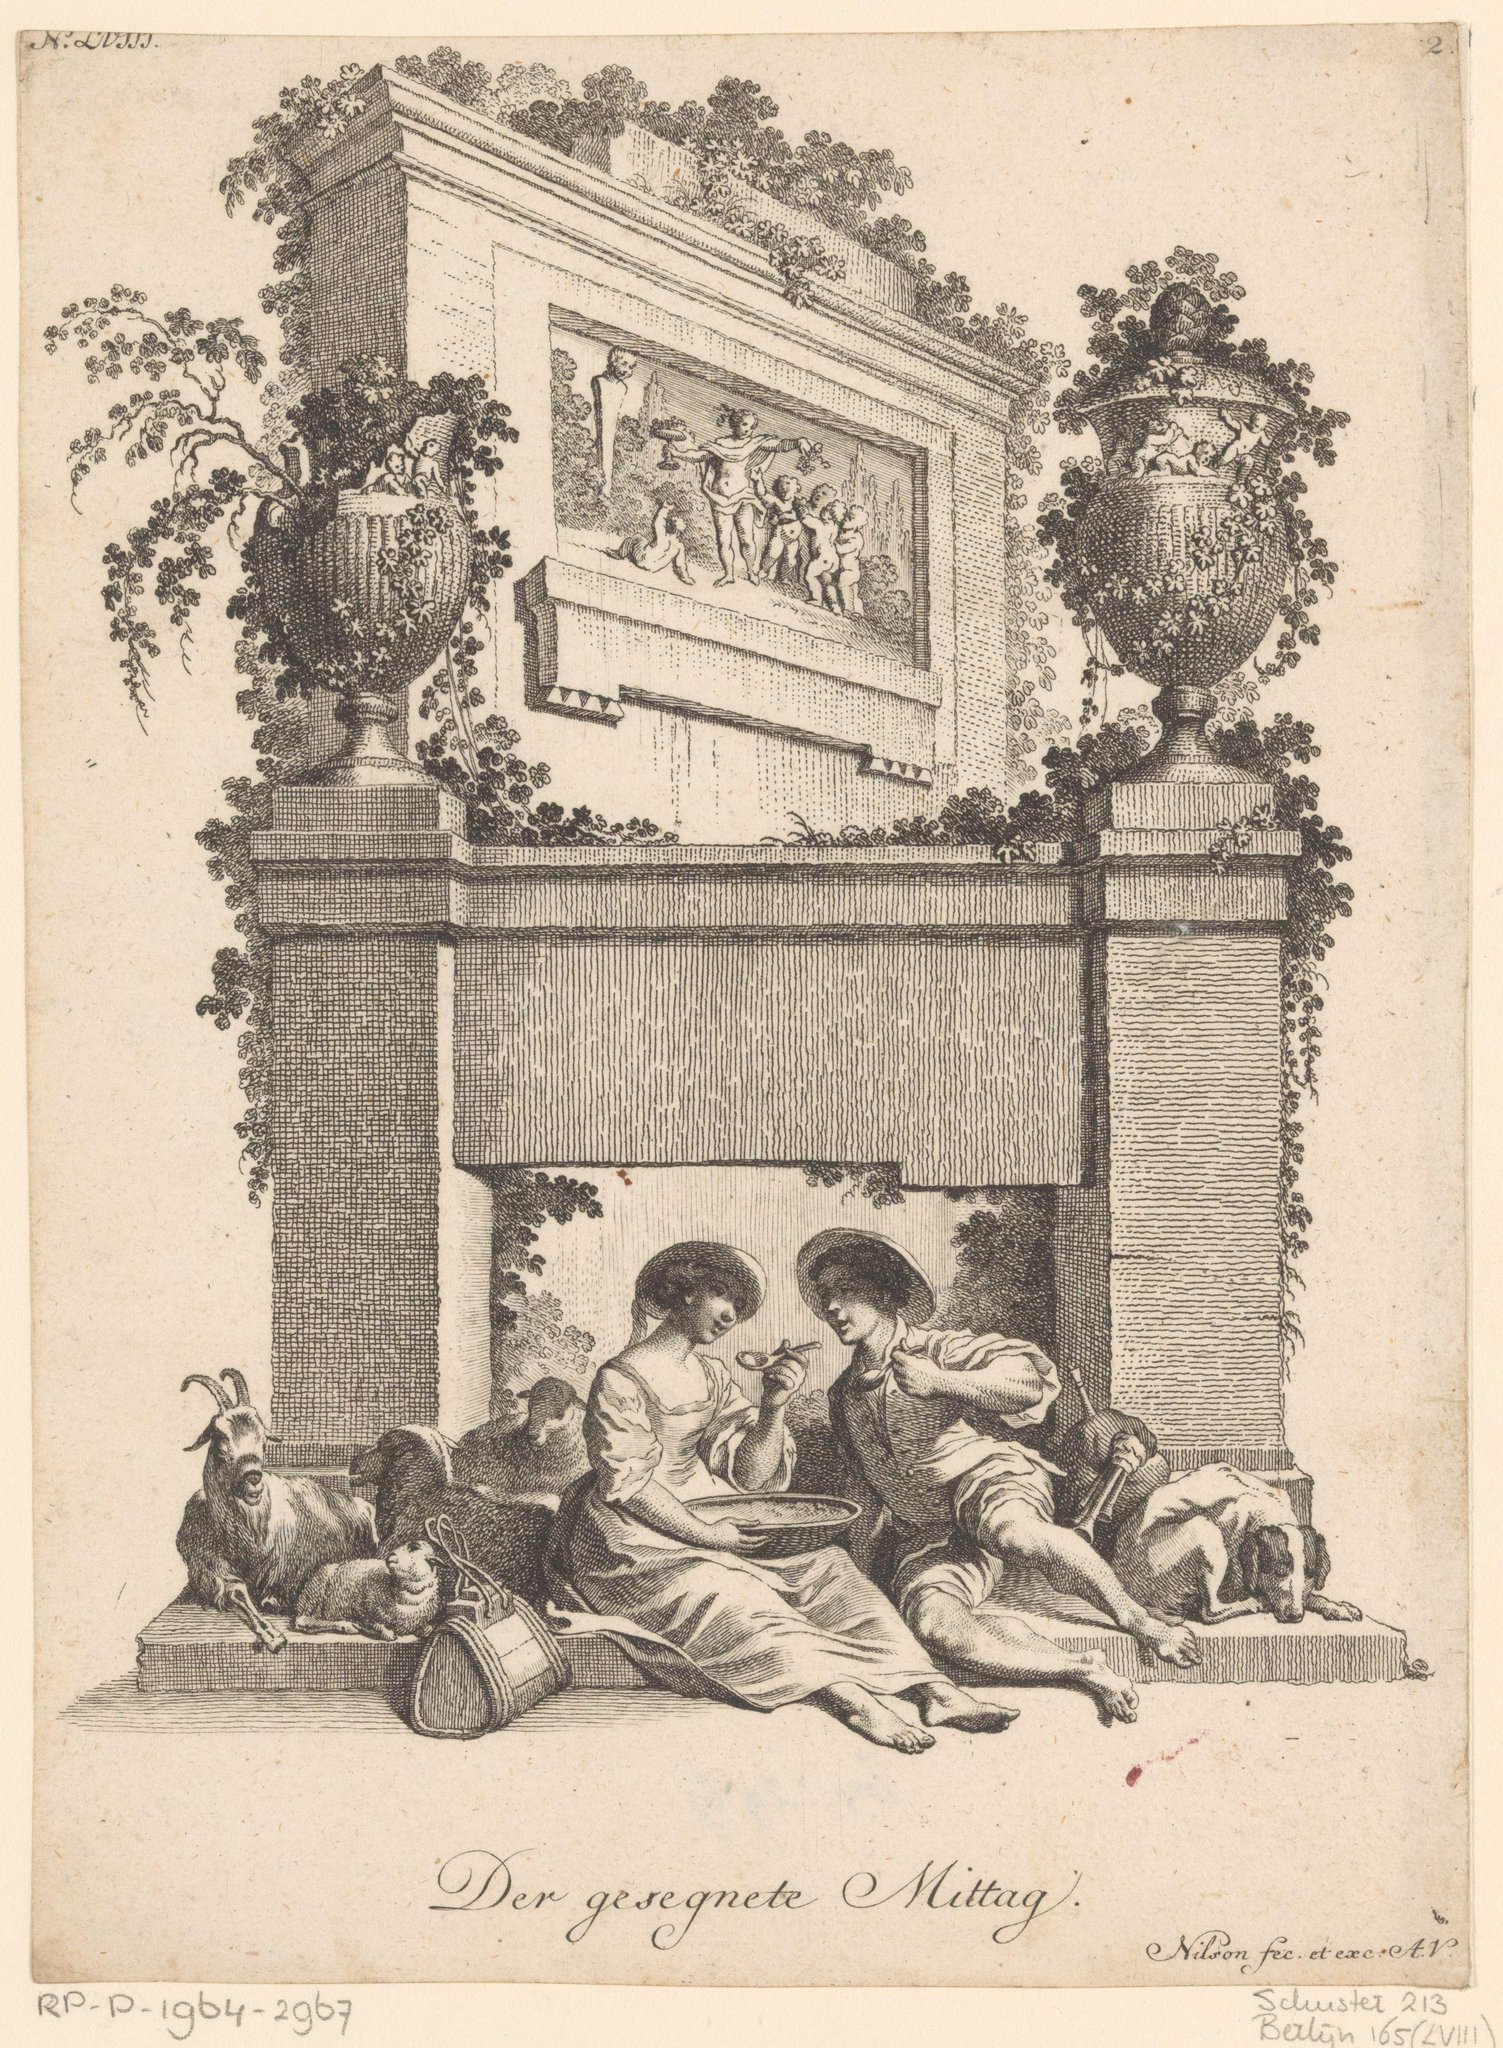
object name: ornament print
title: Dagdelen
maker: johann esaias nilson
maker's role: draughtsman, print maker, publisher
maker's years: 1721-1788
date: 1731-1788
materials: paper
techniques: etching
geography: augsburg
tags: midday meal, lunch, afternoon, pastorals, arcadian scenes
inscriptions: collector's mark: Lugt 2228, collector's mark: Lugt 2760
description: Een herderspaar en hun kudde rusten en lunchen. Zij zitten voor een muur met vazen met bloemen en putti en een fries met voorstelling van Bacchus. Uitgeversnummer LVIII.